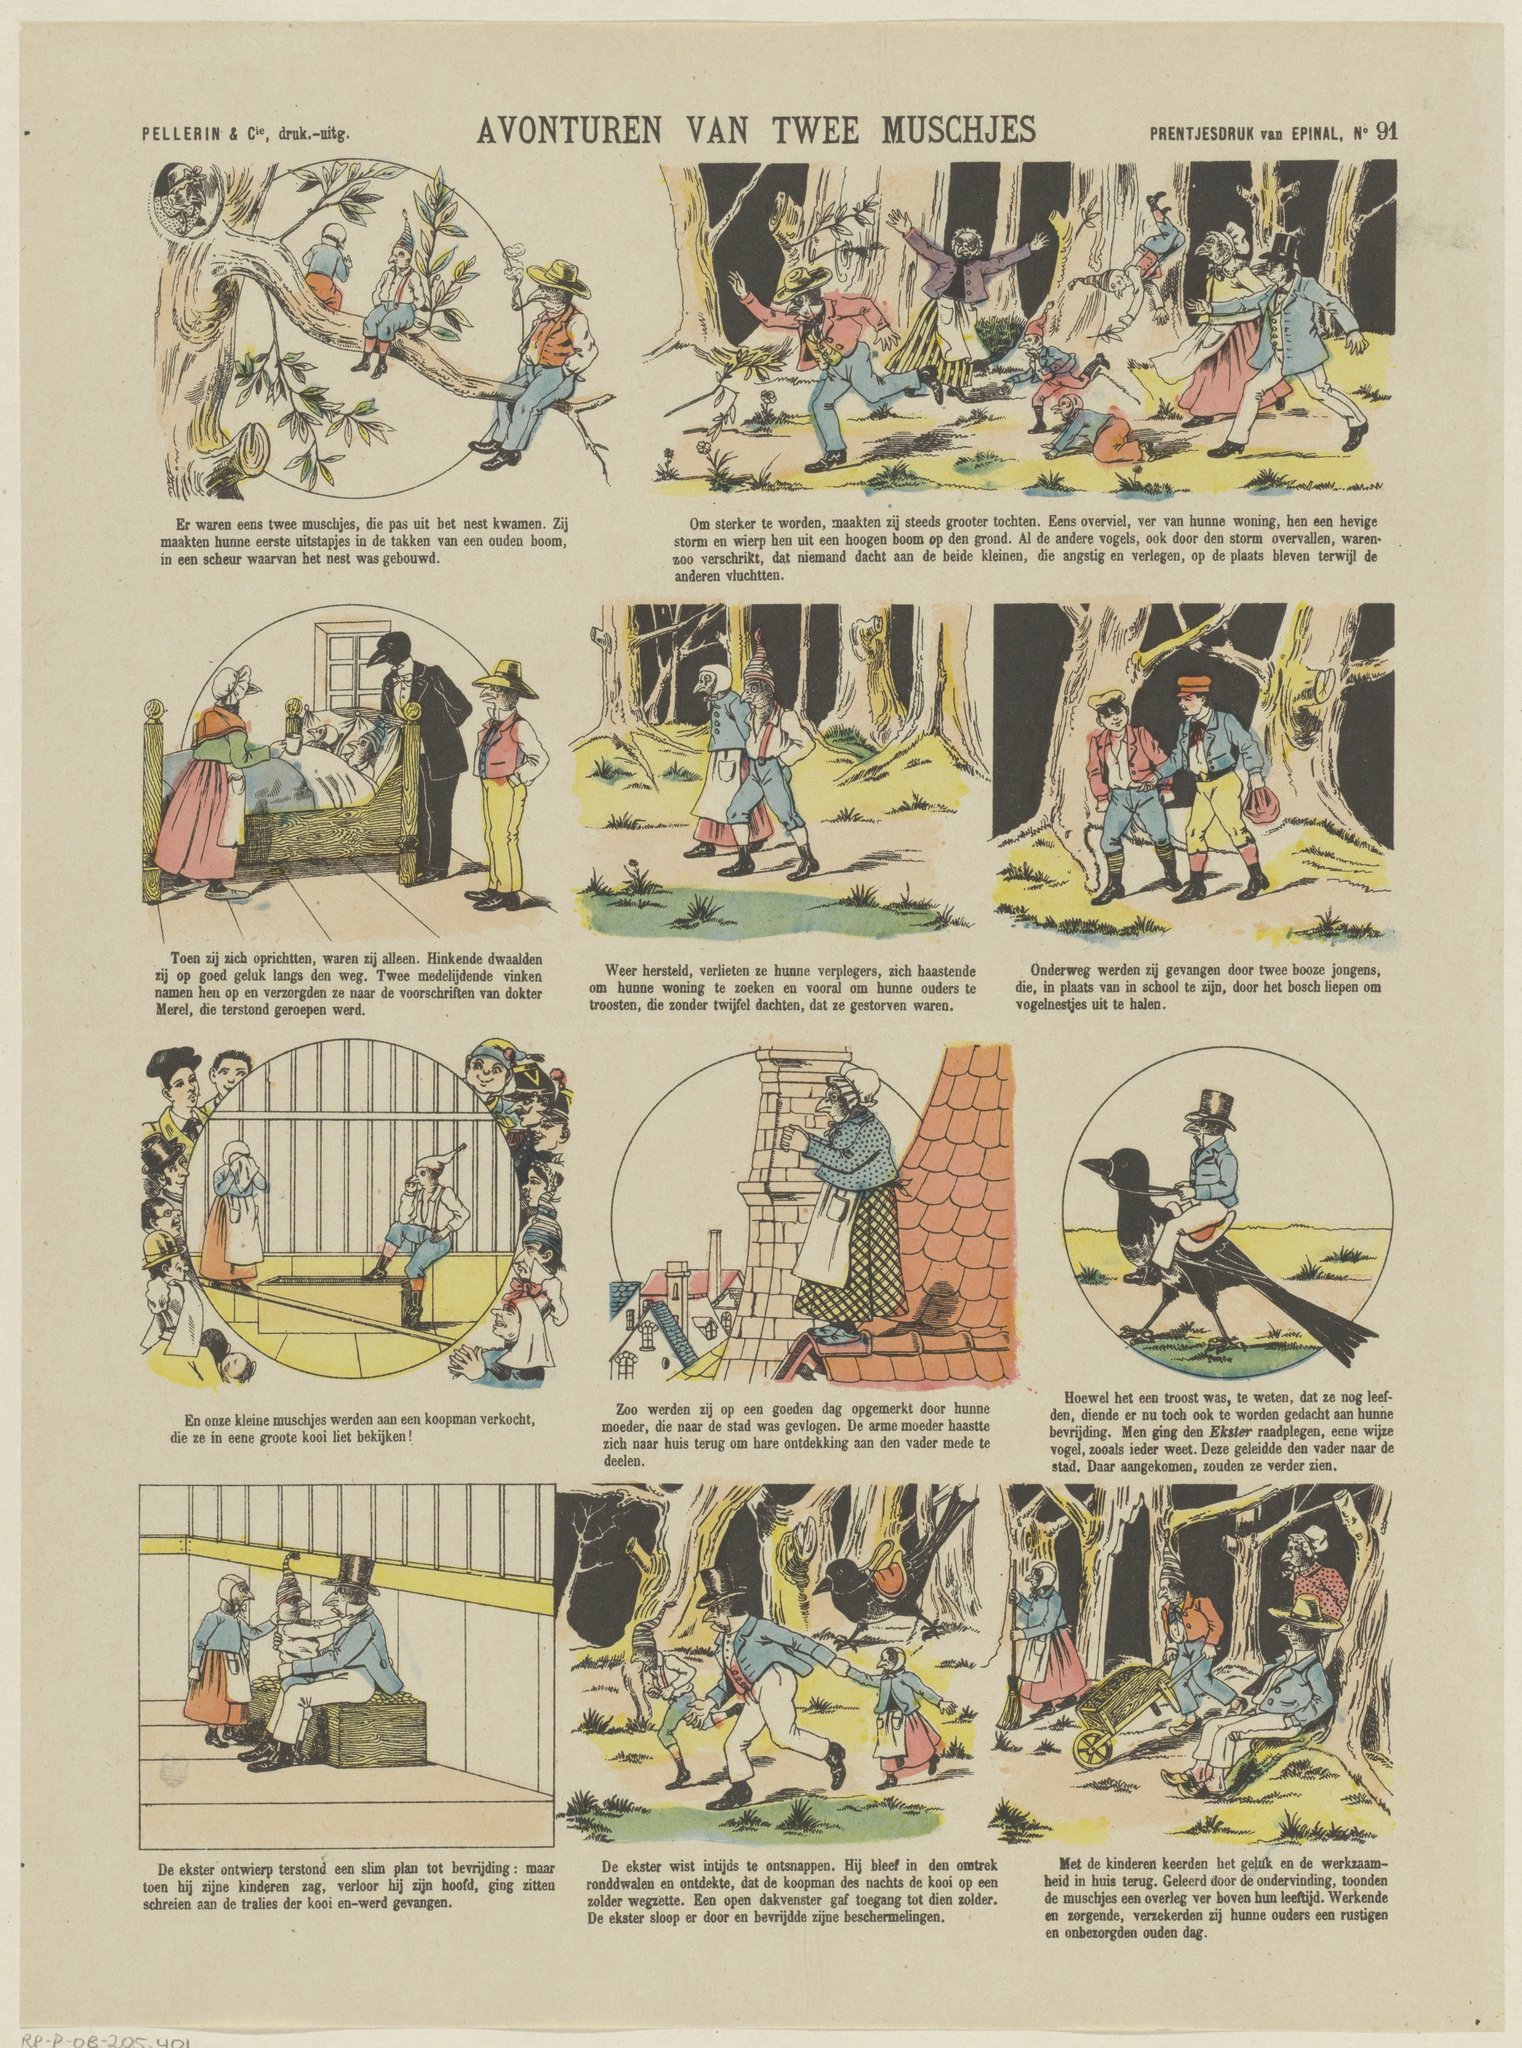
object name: popular print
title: Prentjesdruk van Epinal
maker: Anonymous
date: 1902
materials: paper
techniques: colour, letterpress printing, lithograph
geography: epinal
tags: animals acting as human beings, song-birds: sparrow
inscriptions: collector's mark: Lugt 2760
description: Blad met 11 voorstellingen van mussen die zich als mensen gedragen. Onder elke afbeelding een onderschrift. Genummerd rechtsboven: No 91.